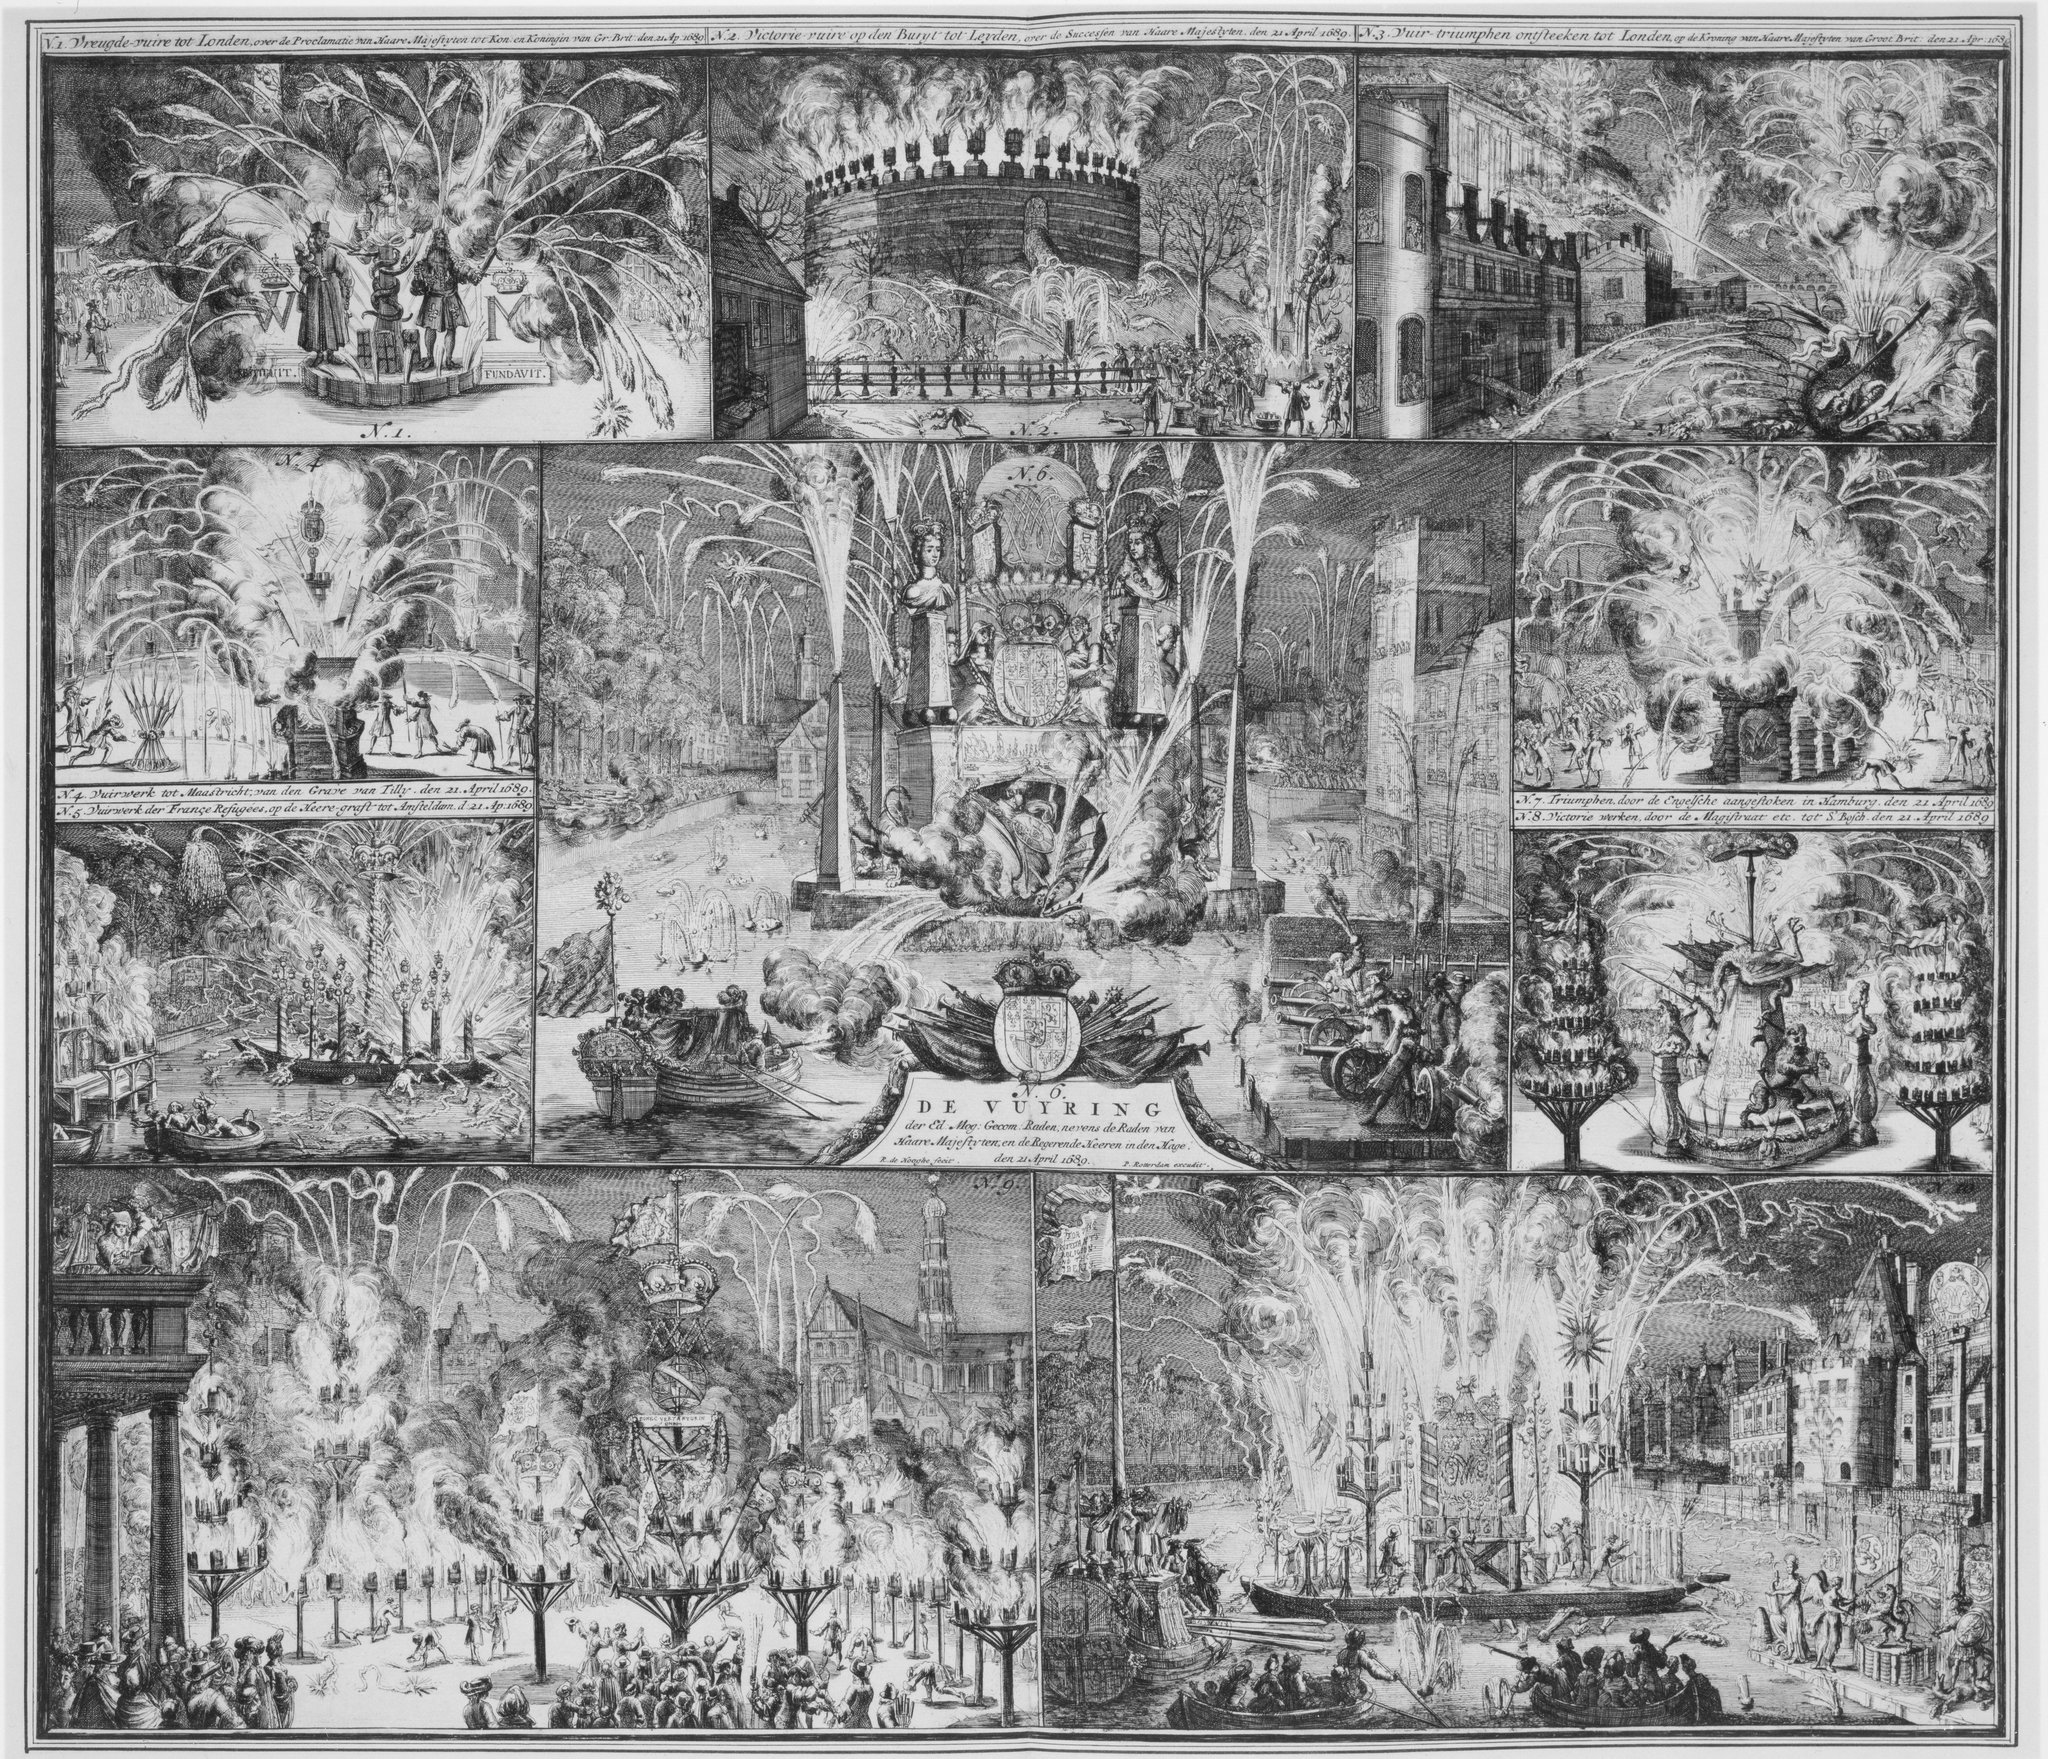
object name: album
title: Accession of William and Mary to the Throne of England, April 21, 1689: Celebrations in London, Hamburg, and the Northern Netherlands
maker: romeyn de hooghe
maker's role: artist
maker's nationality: dutch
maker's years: 1645-1708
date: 1689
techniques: engraving, etching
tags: fireworks,virgin mary,crowd,coat of arms,ships